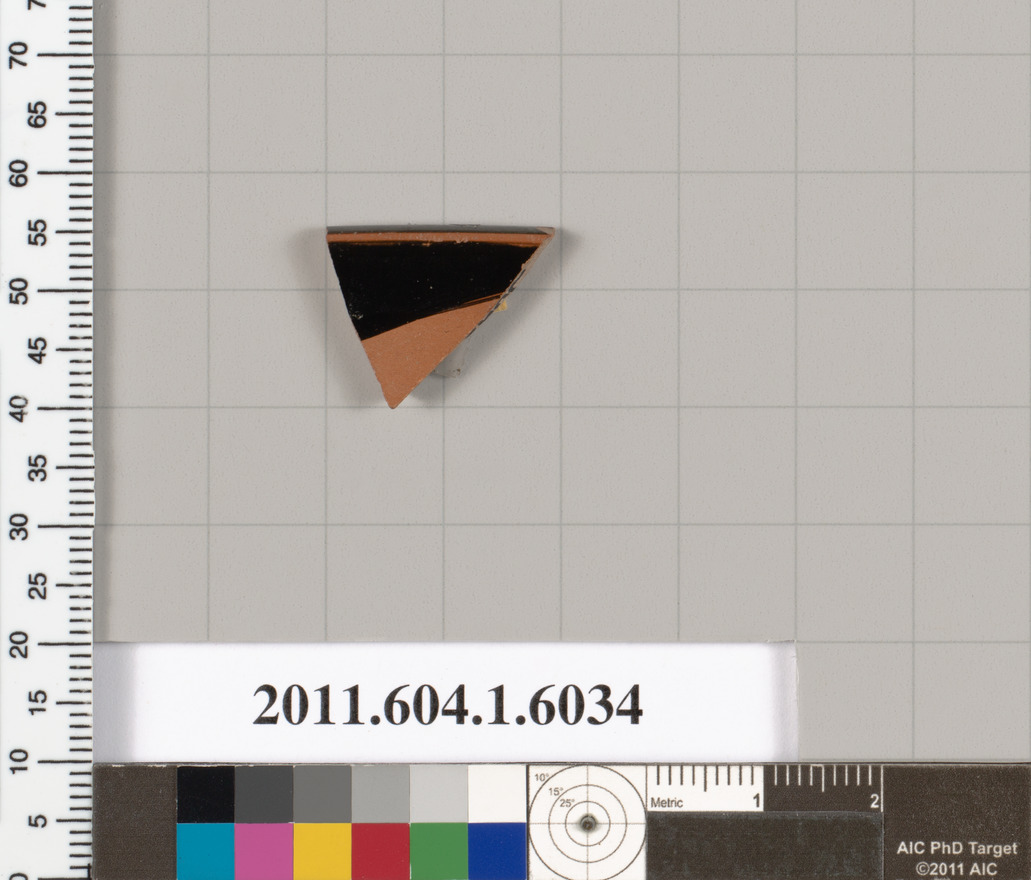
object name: kylix fragment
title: Terracotta rim fragment of a kylix (drinking cup)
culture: greek, attic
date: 510-500 BCE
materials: terracotta